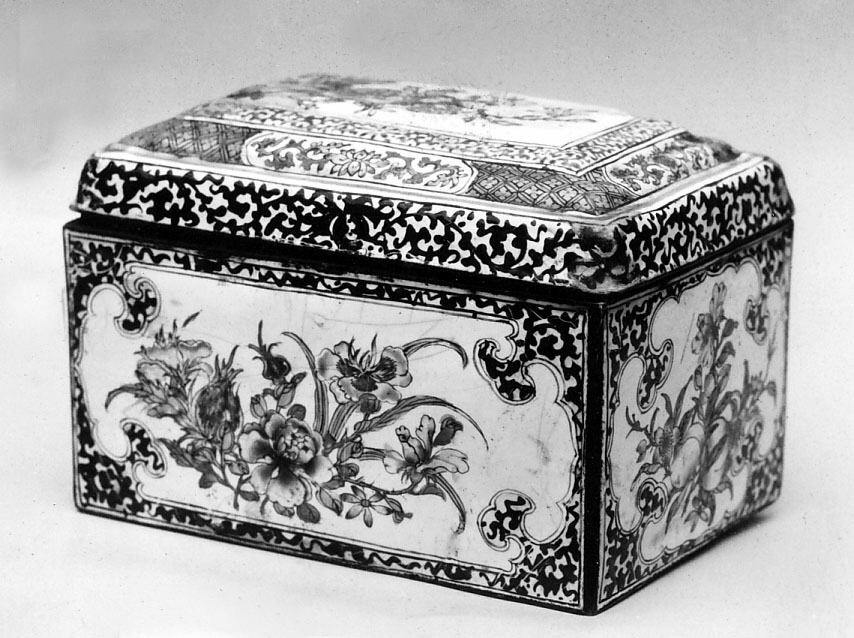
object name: box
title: Box with Hinged Cover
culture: chinese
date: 1801-1900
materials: enamel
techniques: painting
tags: flowers